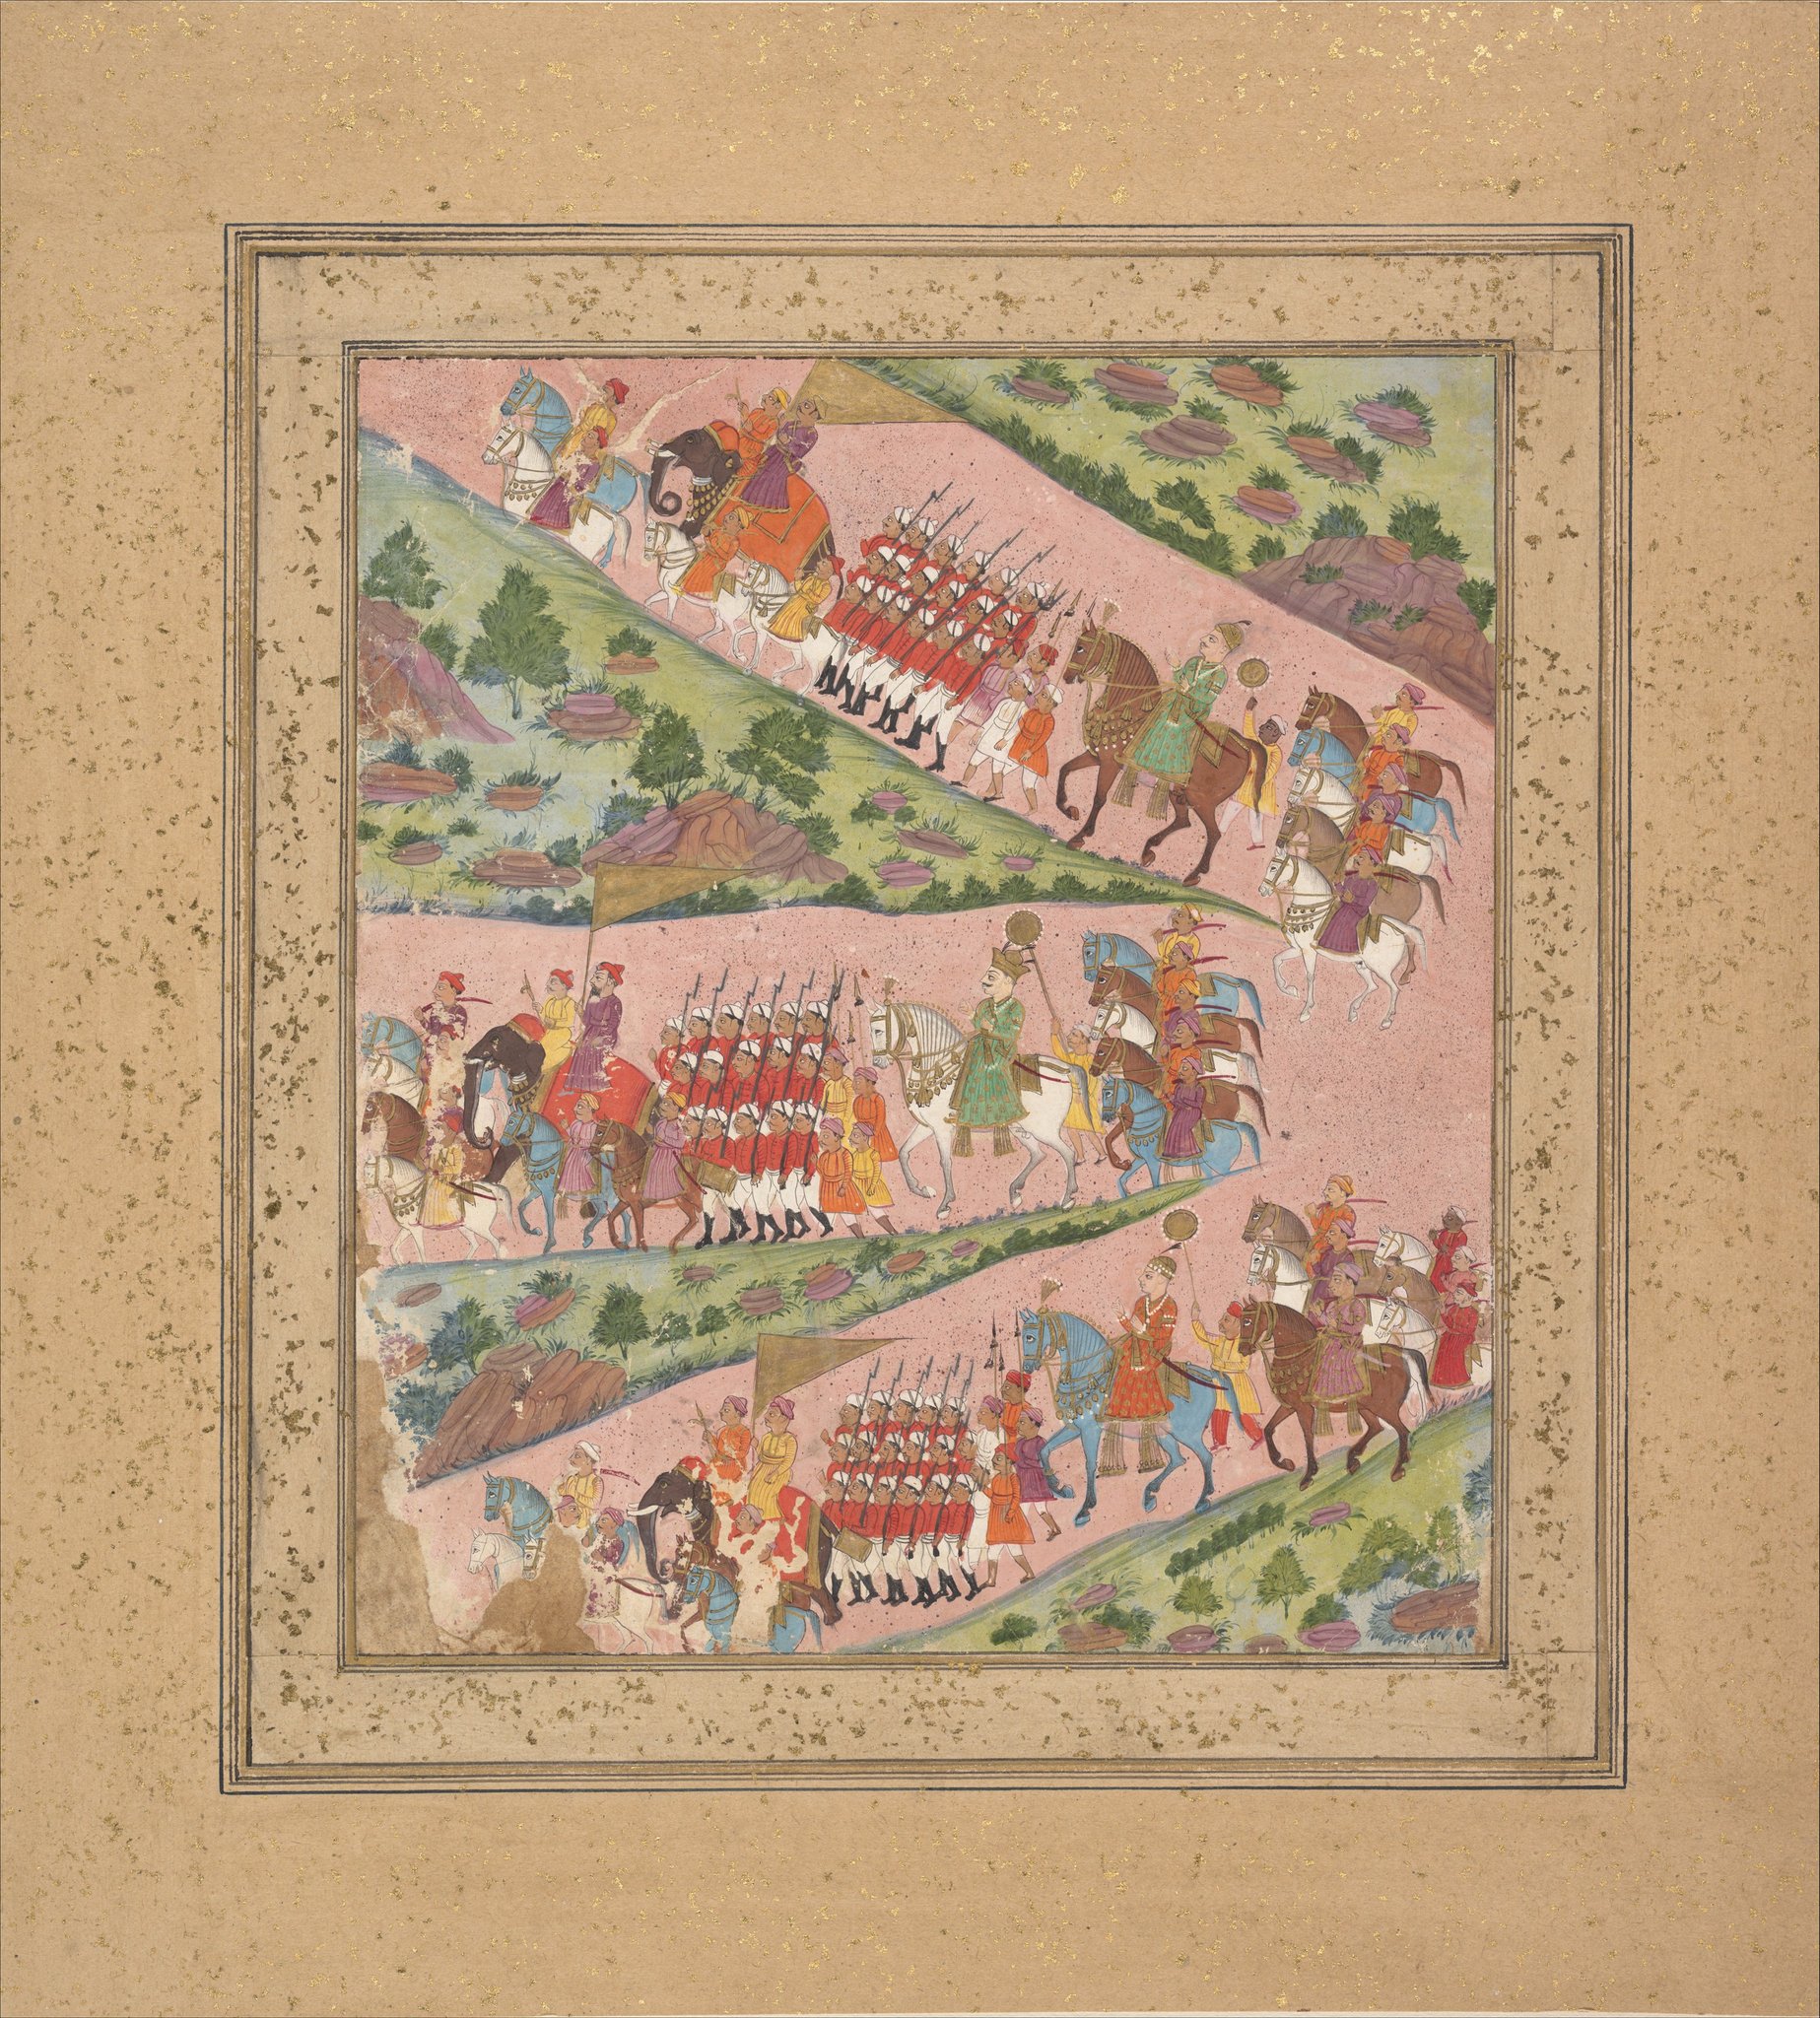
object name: painting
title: The Three Roads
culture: indian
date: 1840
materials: ink, paper, watercolor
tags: roads,soldiers,men,elephants,horses